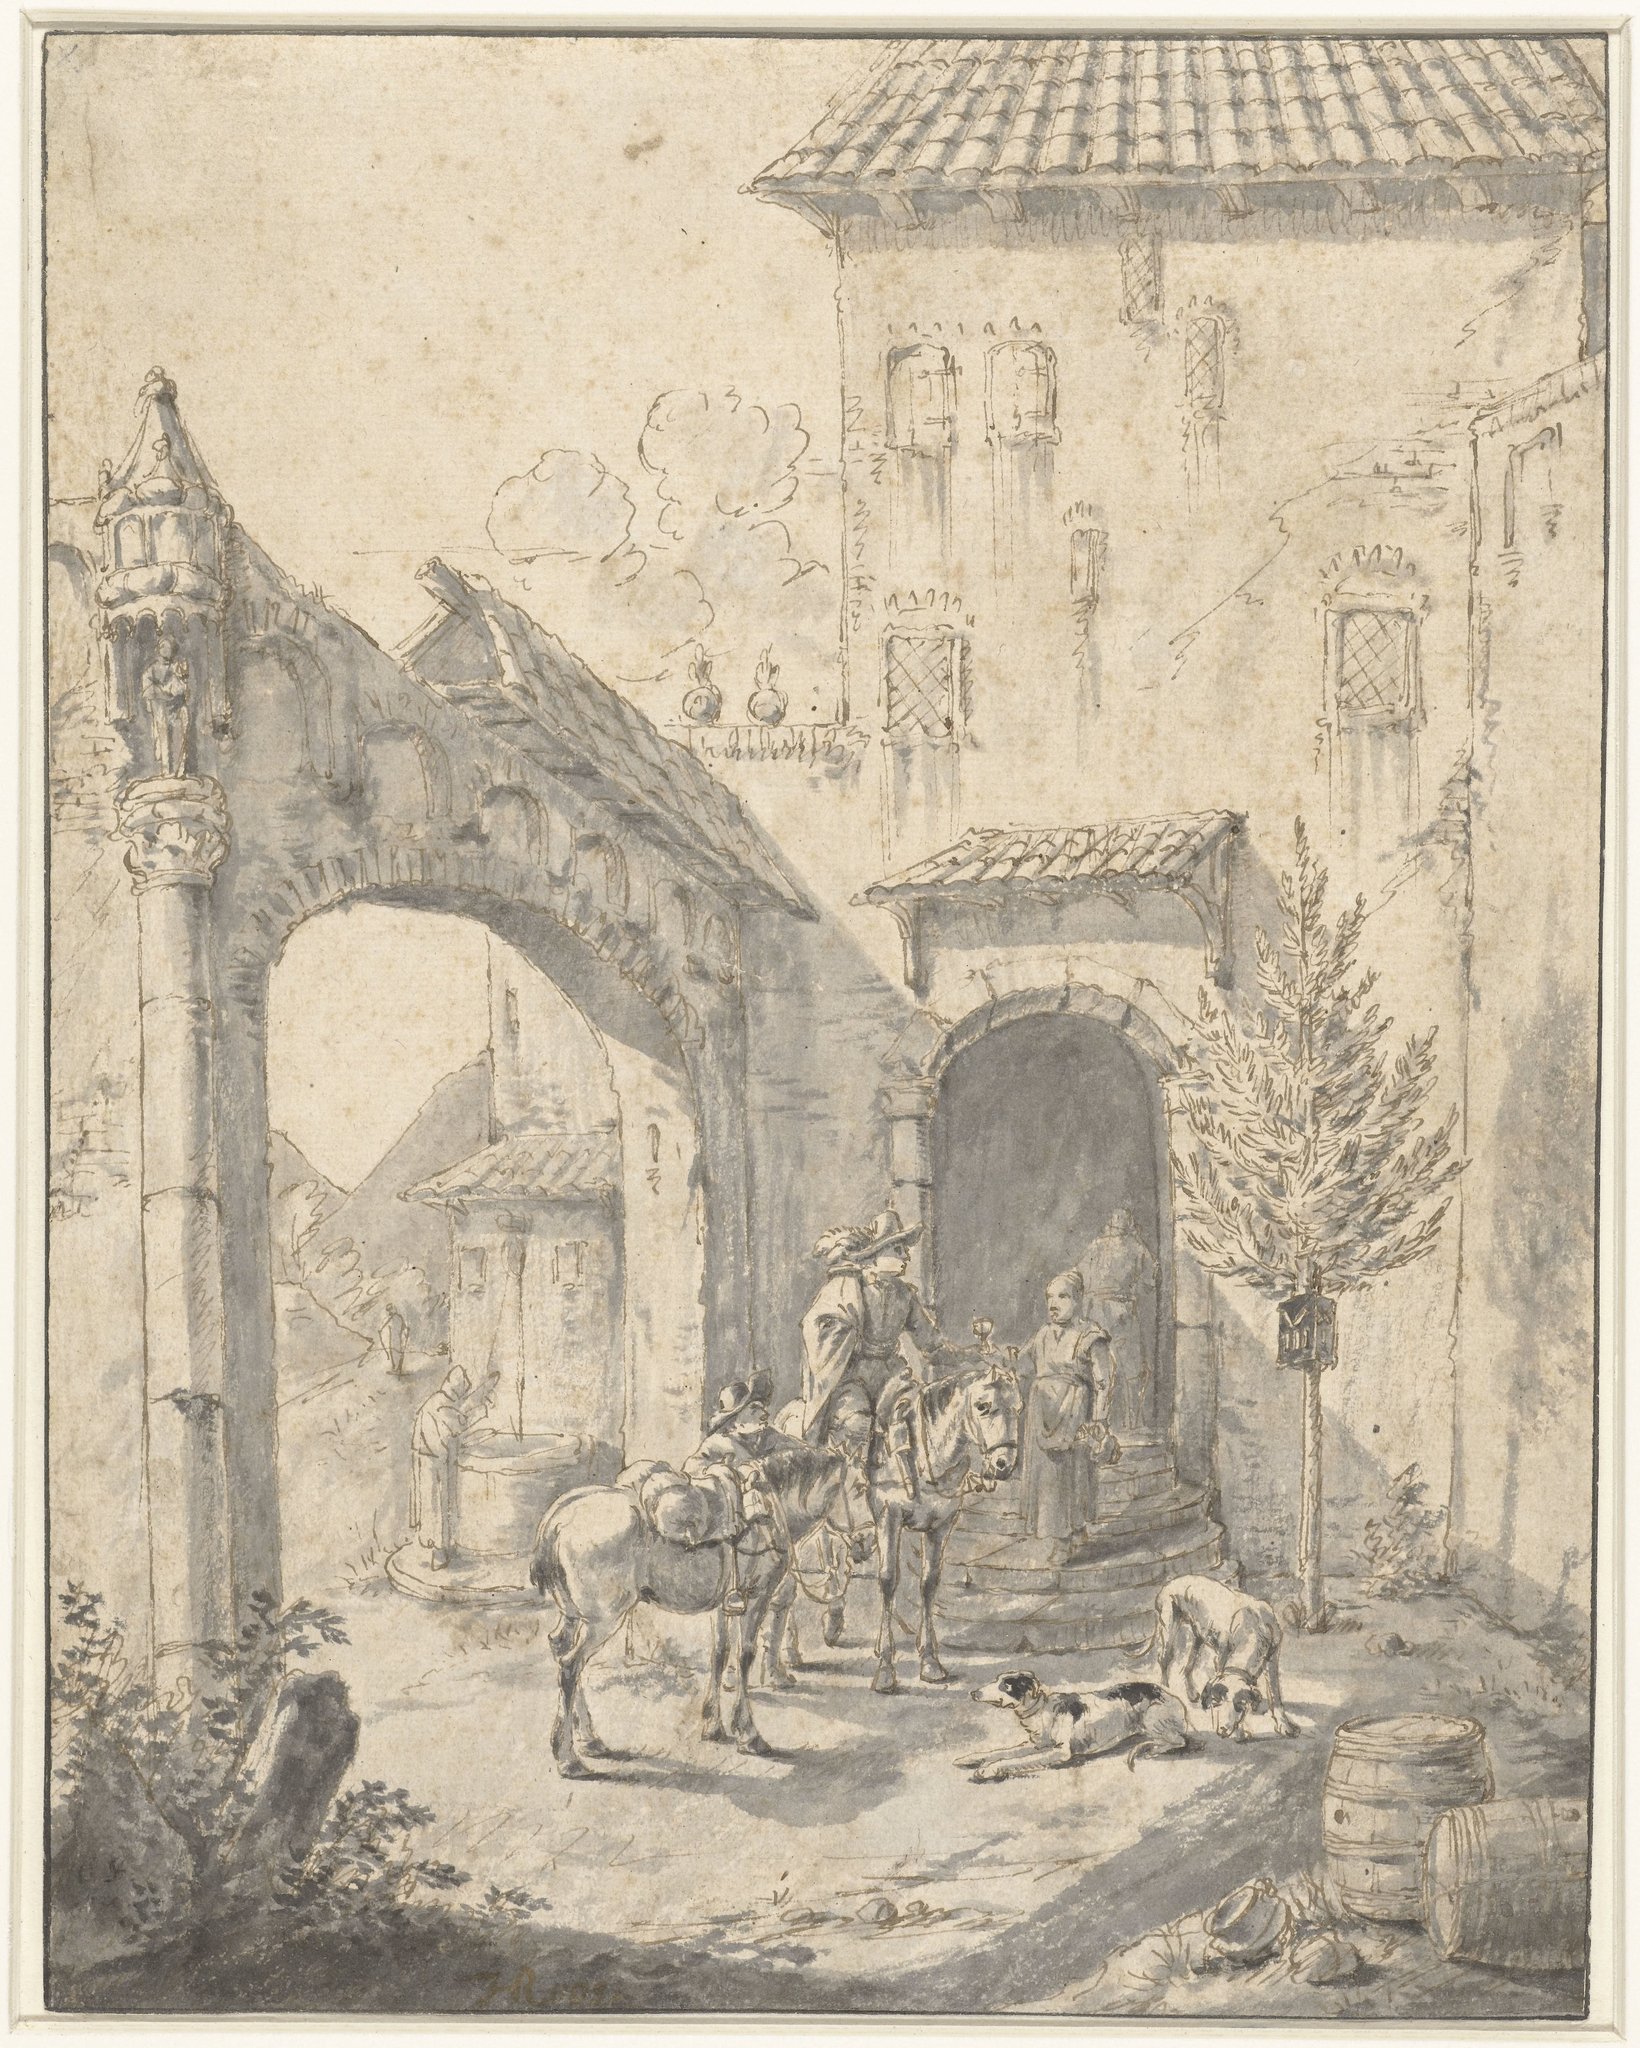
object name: drawing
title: Twee ruiters pleisteren op de voorhoof van een herberg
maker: johann heinrich roos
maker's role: draughtsman, print maker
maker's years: 1631-1685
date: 1641-1685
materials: ink, paper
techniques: brush, pen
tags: hotel, hostelry, inn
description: Twee ruiters pleisteren op de voorhoof van een herberg met een monumentale poort.